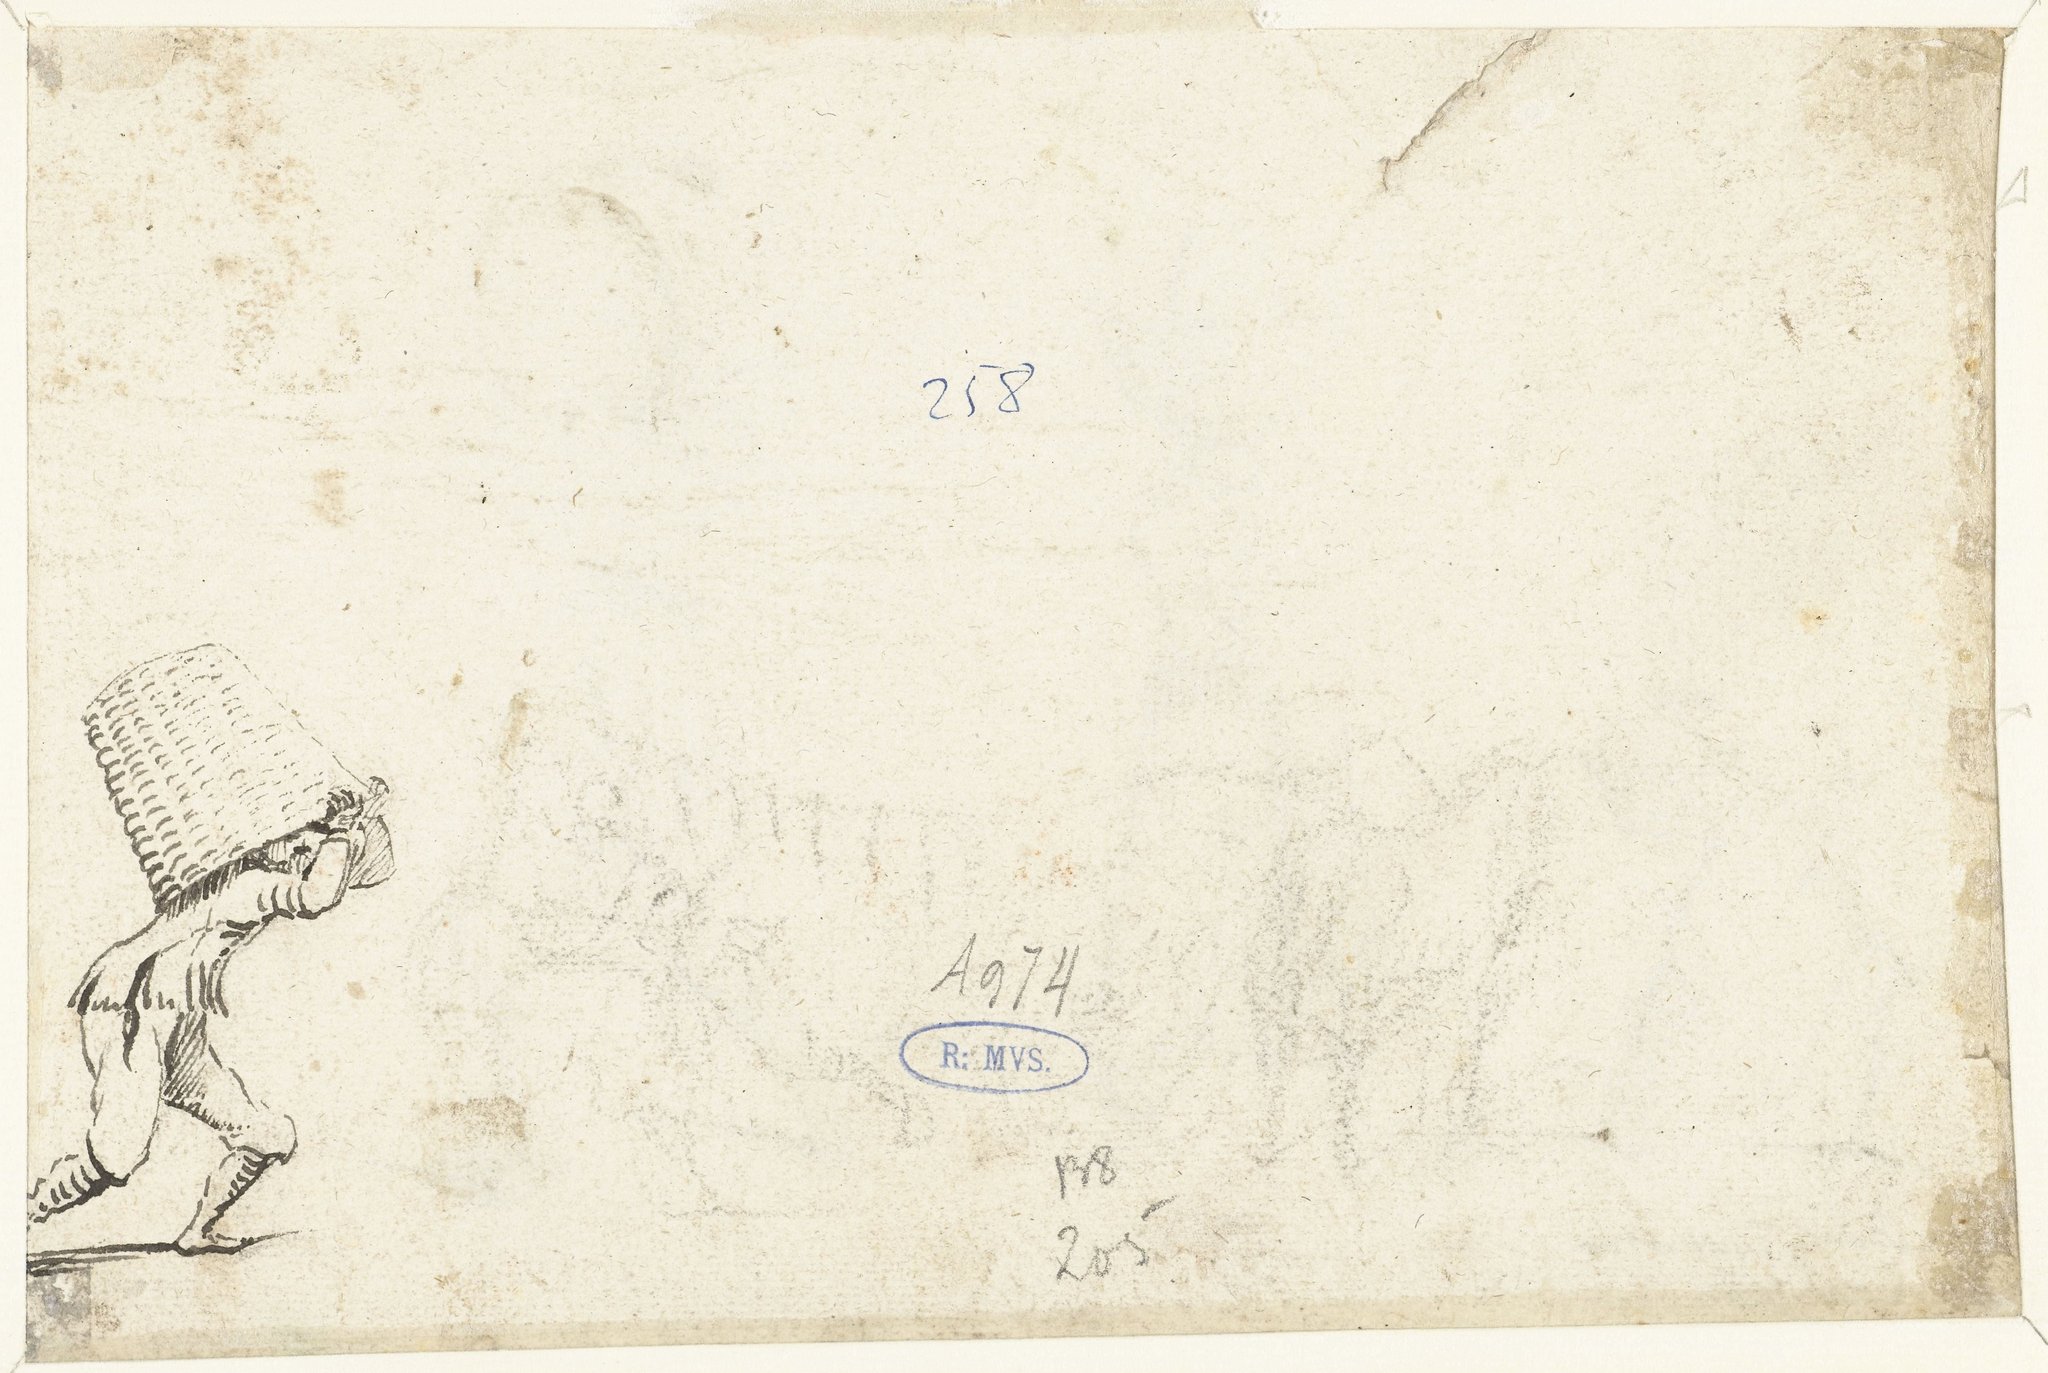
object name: drawing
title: Man die een mand op zijn hoofd draagt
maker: harmen ter borch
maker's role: draughtsman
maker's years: 1638-1677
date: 1650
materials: ink, paper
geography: zwolle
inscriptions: date